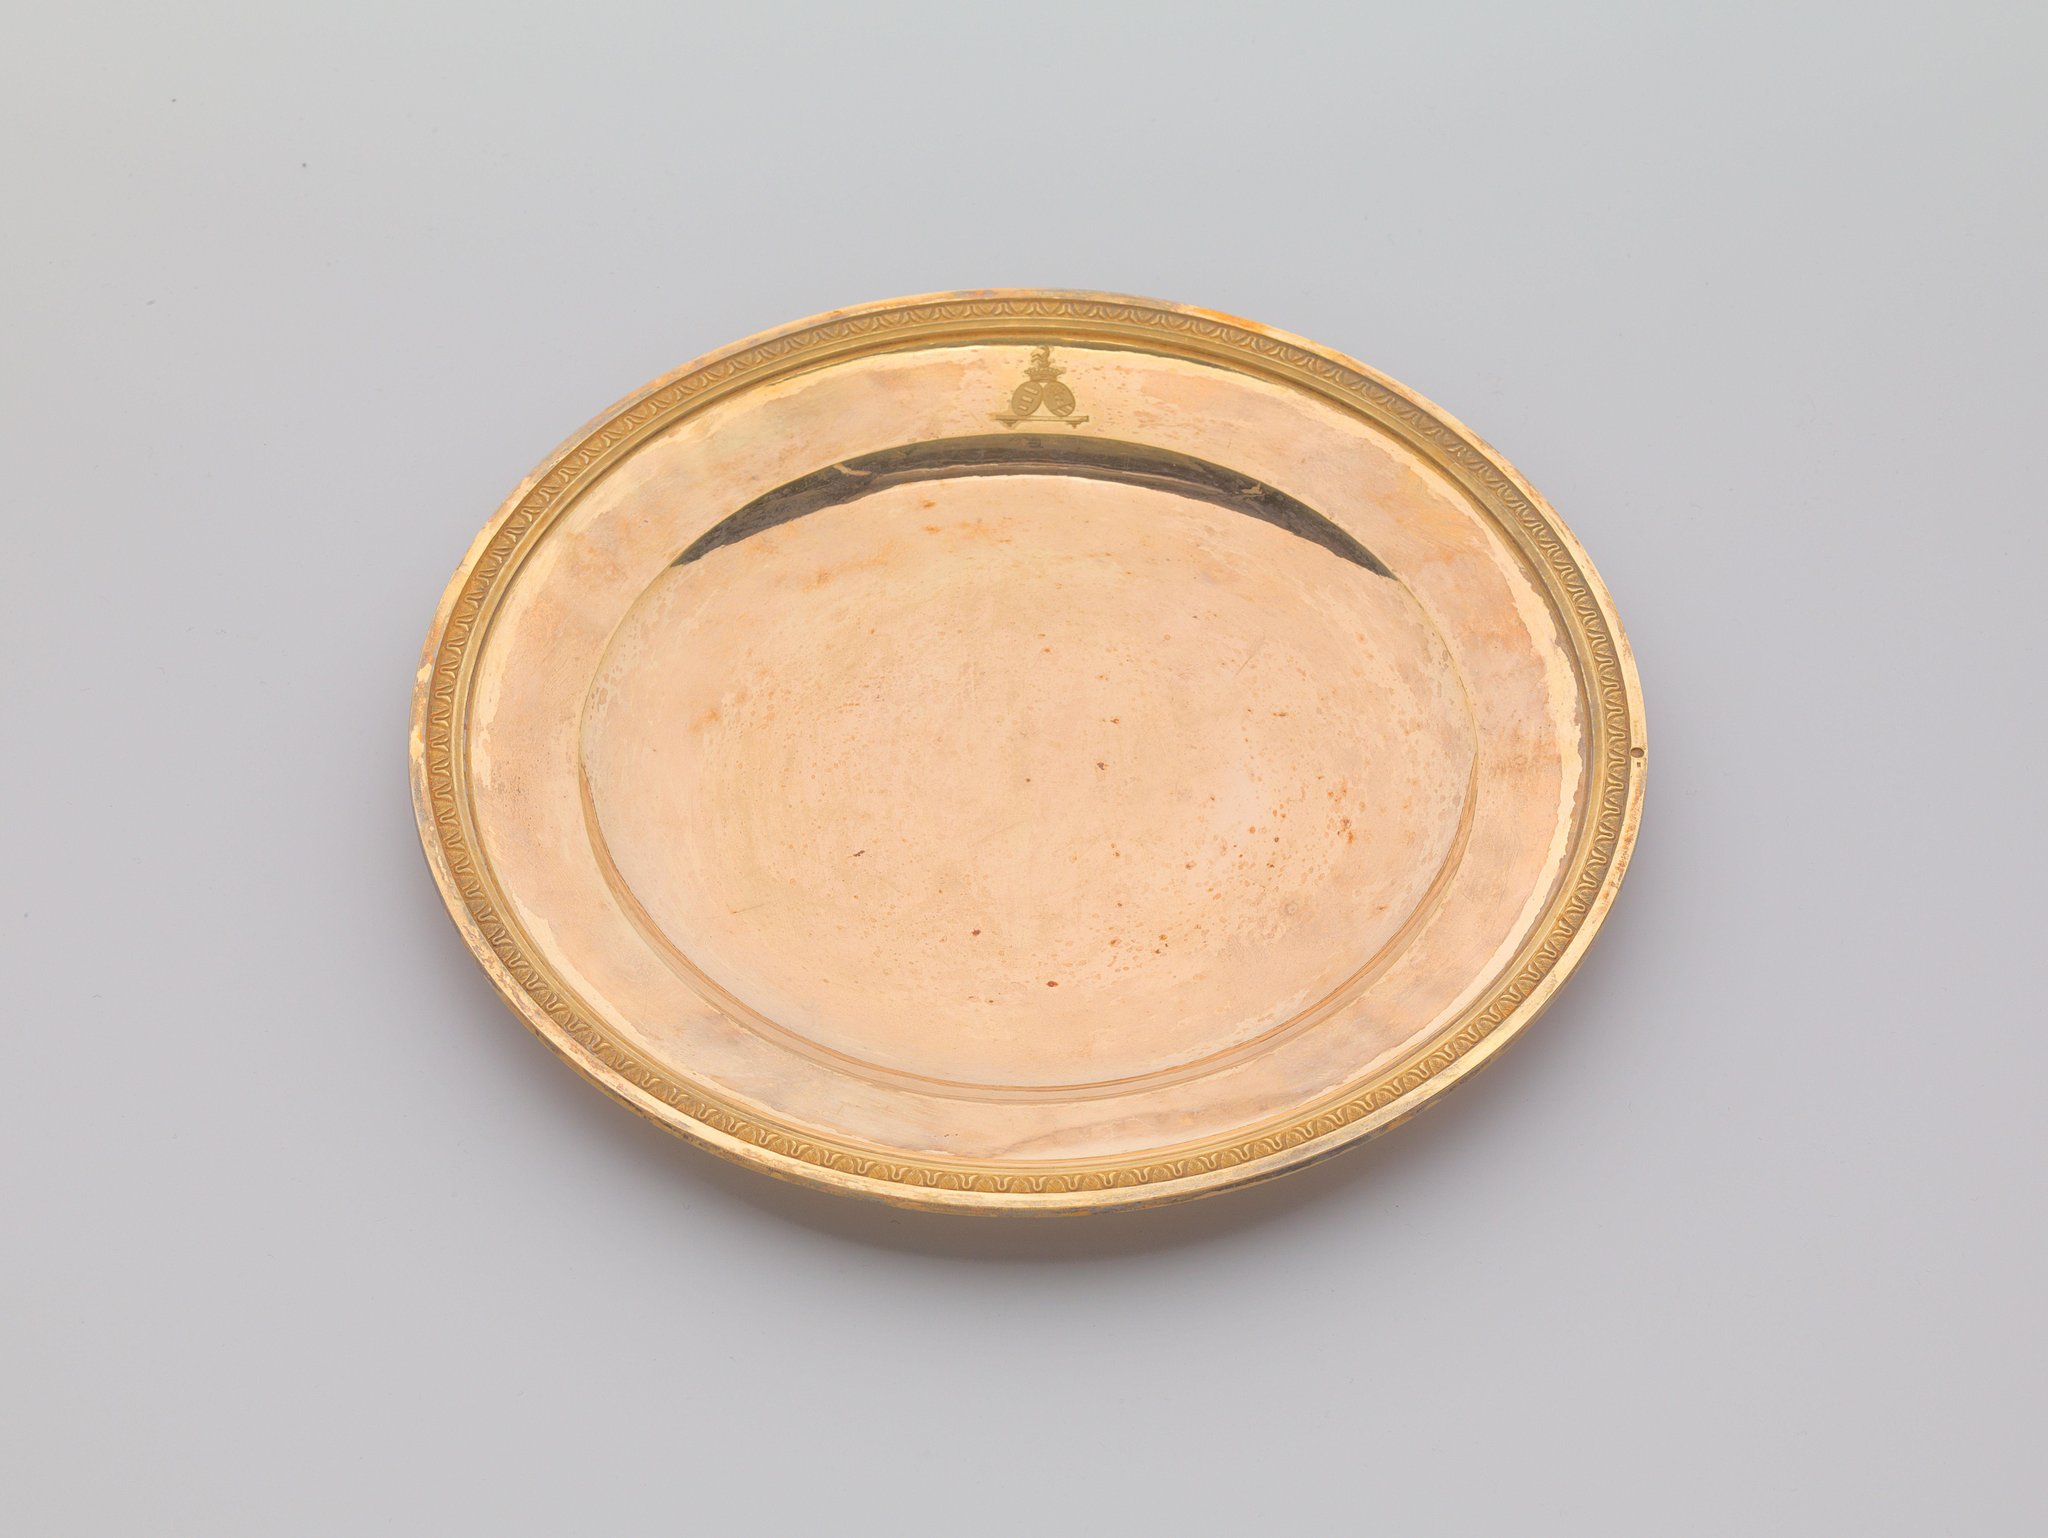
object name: plate dish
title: Bord van verguld zilver, met palmetrand. Op het plat het gegraveerde wapen Potemkin.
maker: Anonymous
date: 1809-1819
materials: silver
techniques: gilding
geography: paris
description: Empire bord van verguld zilver. Omgeven door een palmetrand. In het plat het gegraveerde wapen van Potemkin.